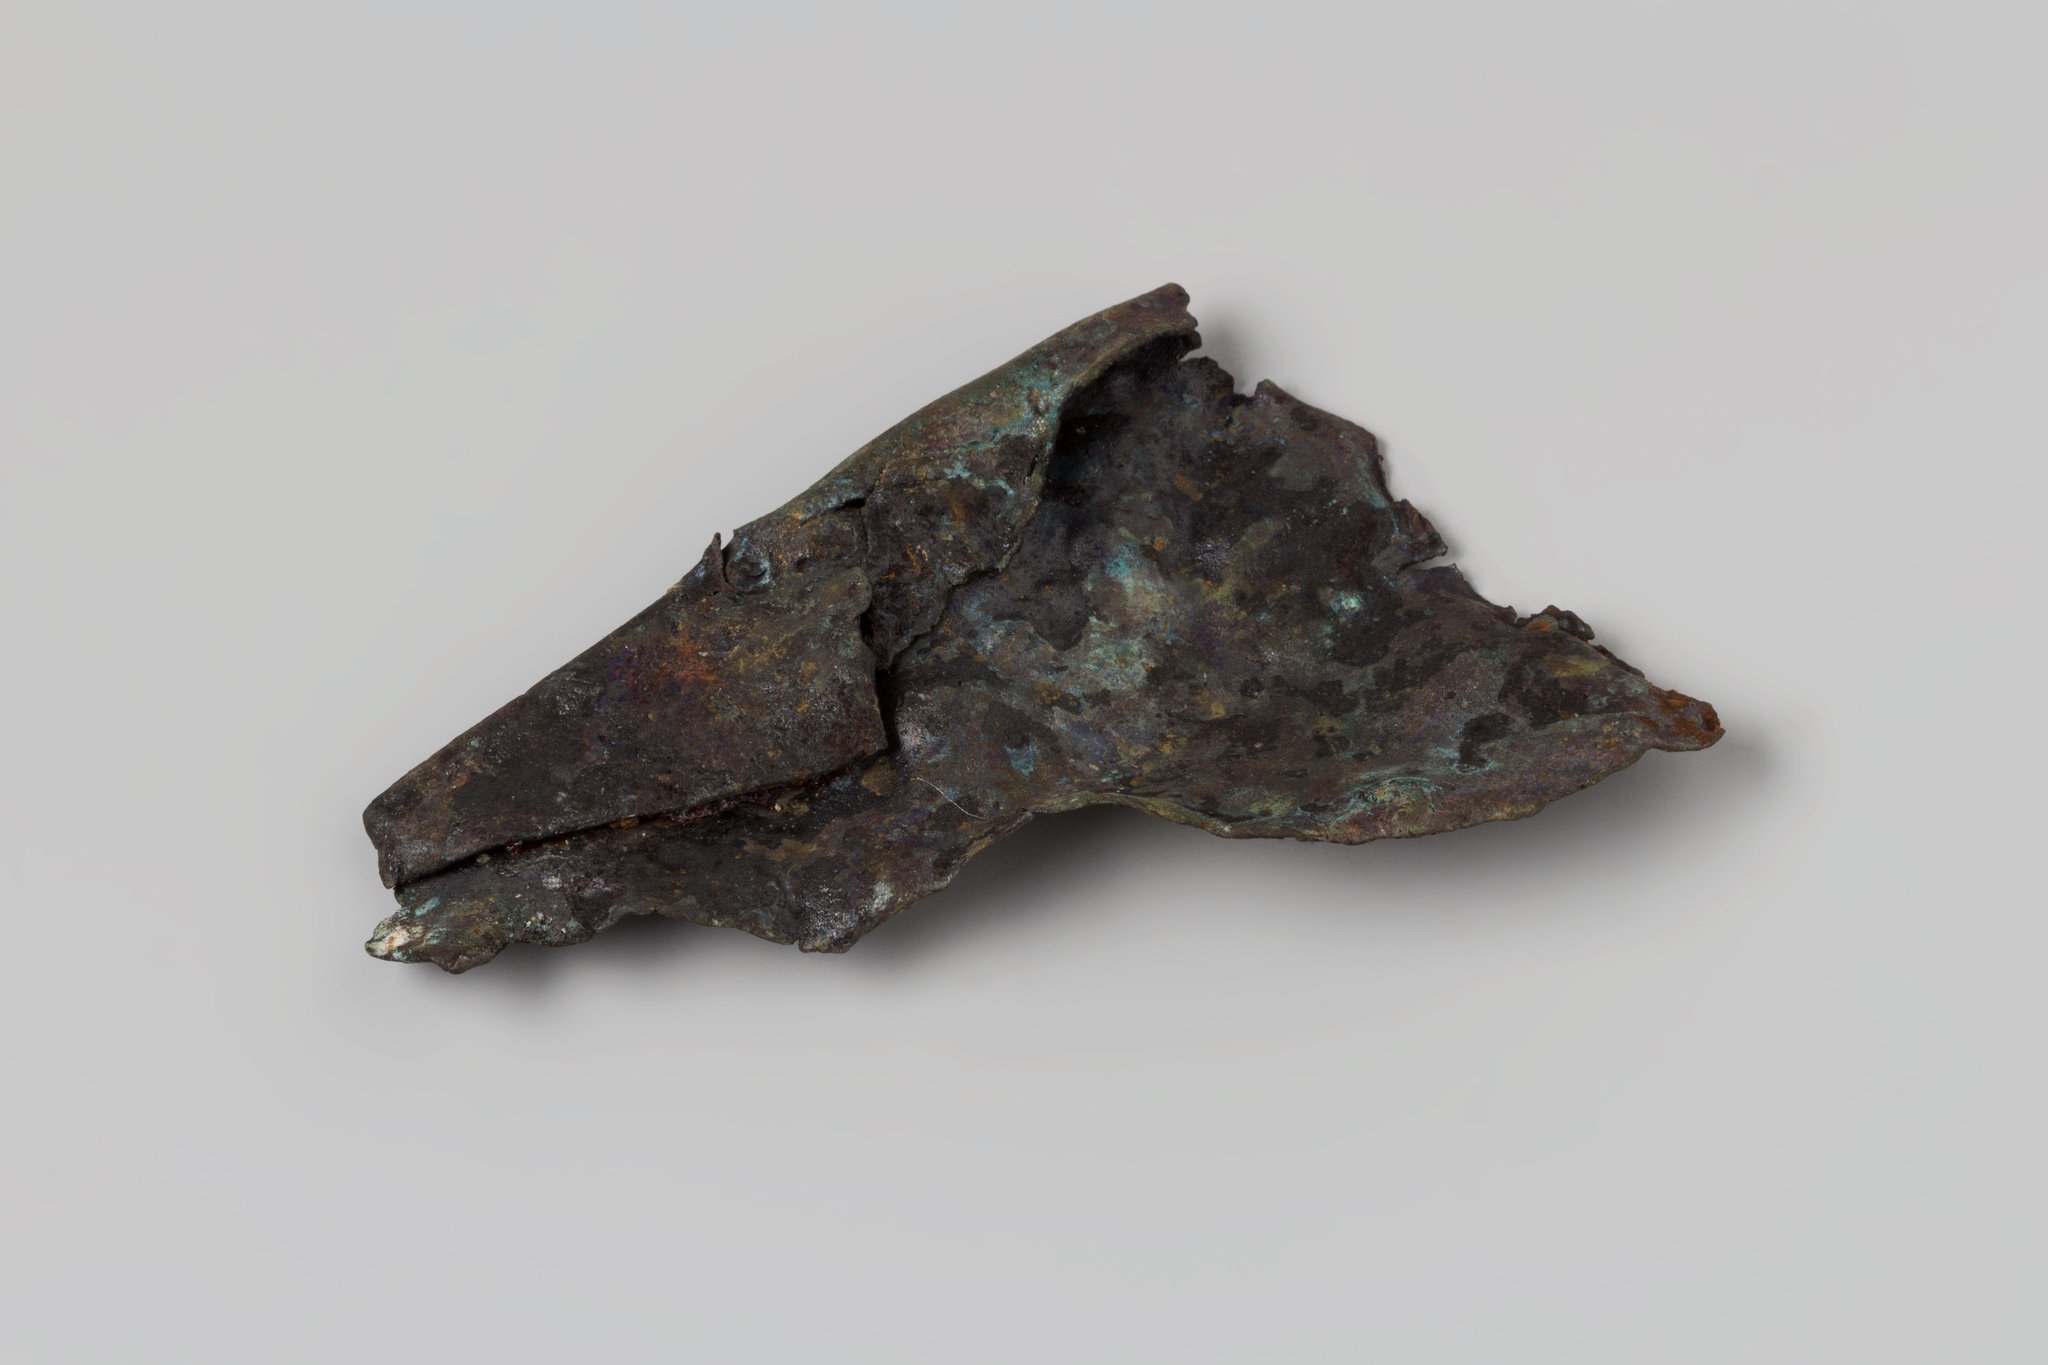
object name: scheepswrakvondst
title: Fragment van koper uit het wrak van de Oost-Indiëvaarder Hollandia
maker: Anonymous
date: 1700-1743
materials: copper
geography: netherlands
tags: verenigde oostindische compagnie, hollandia (schip), annet